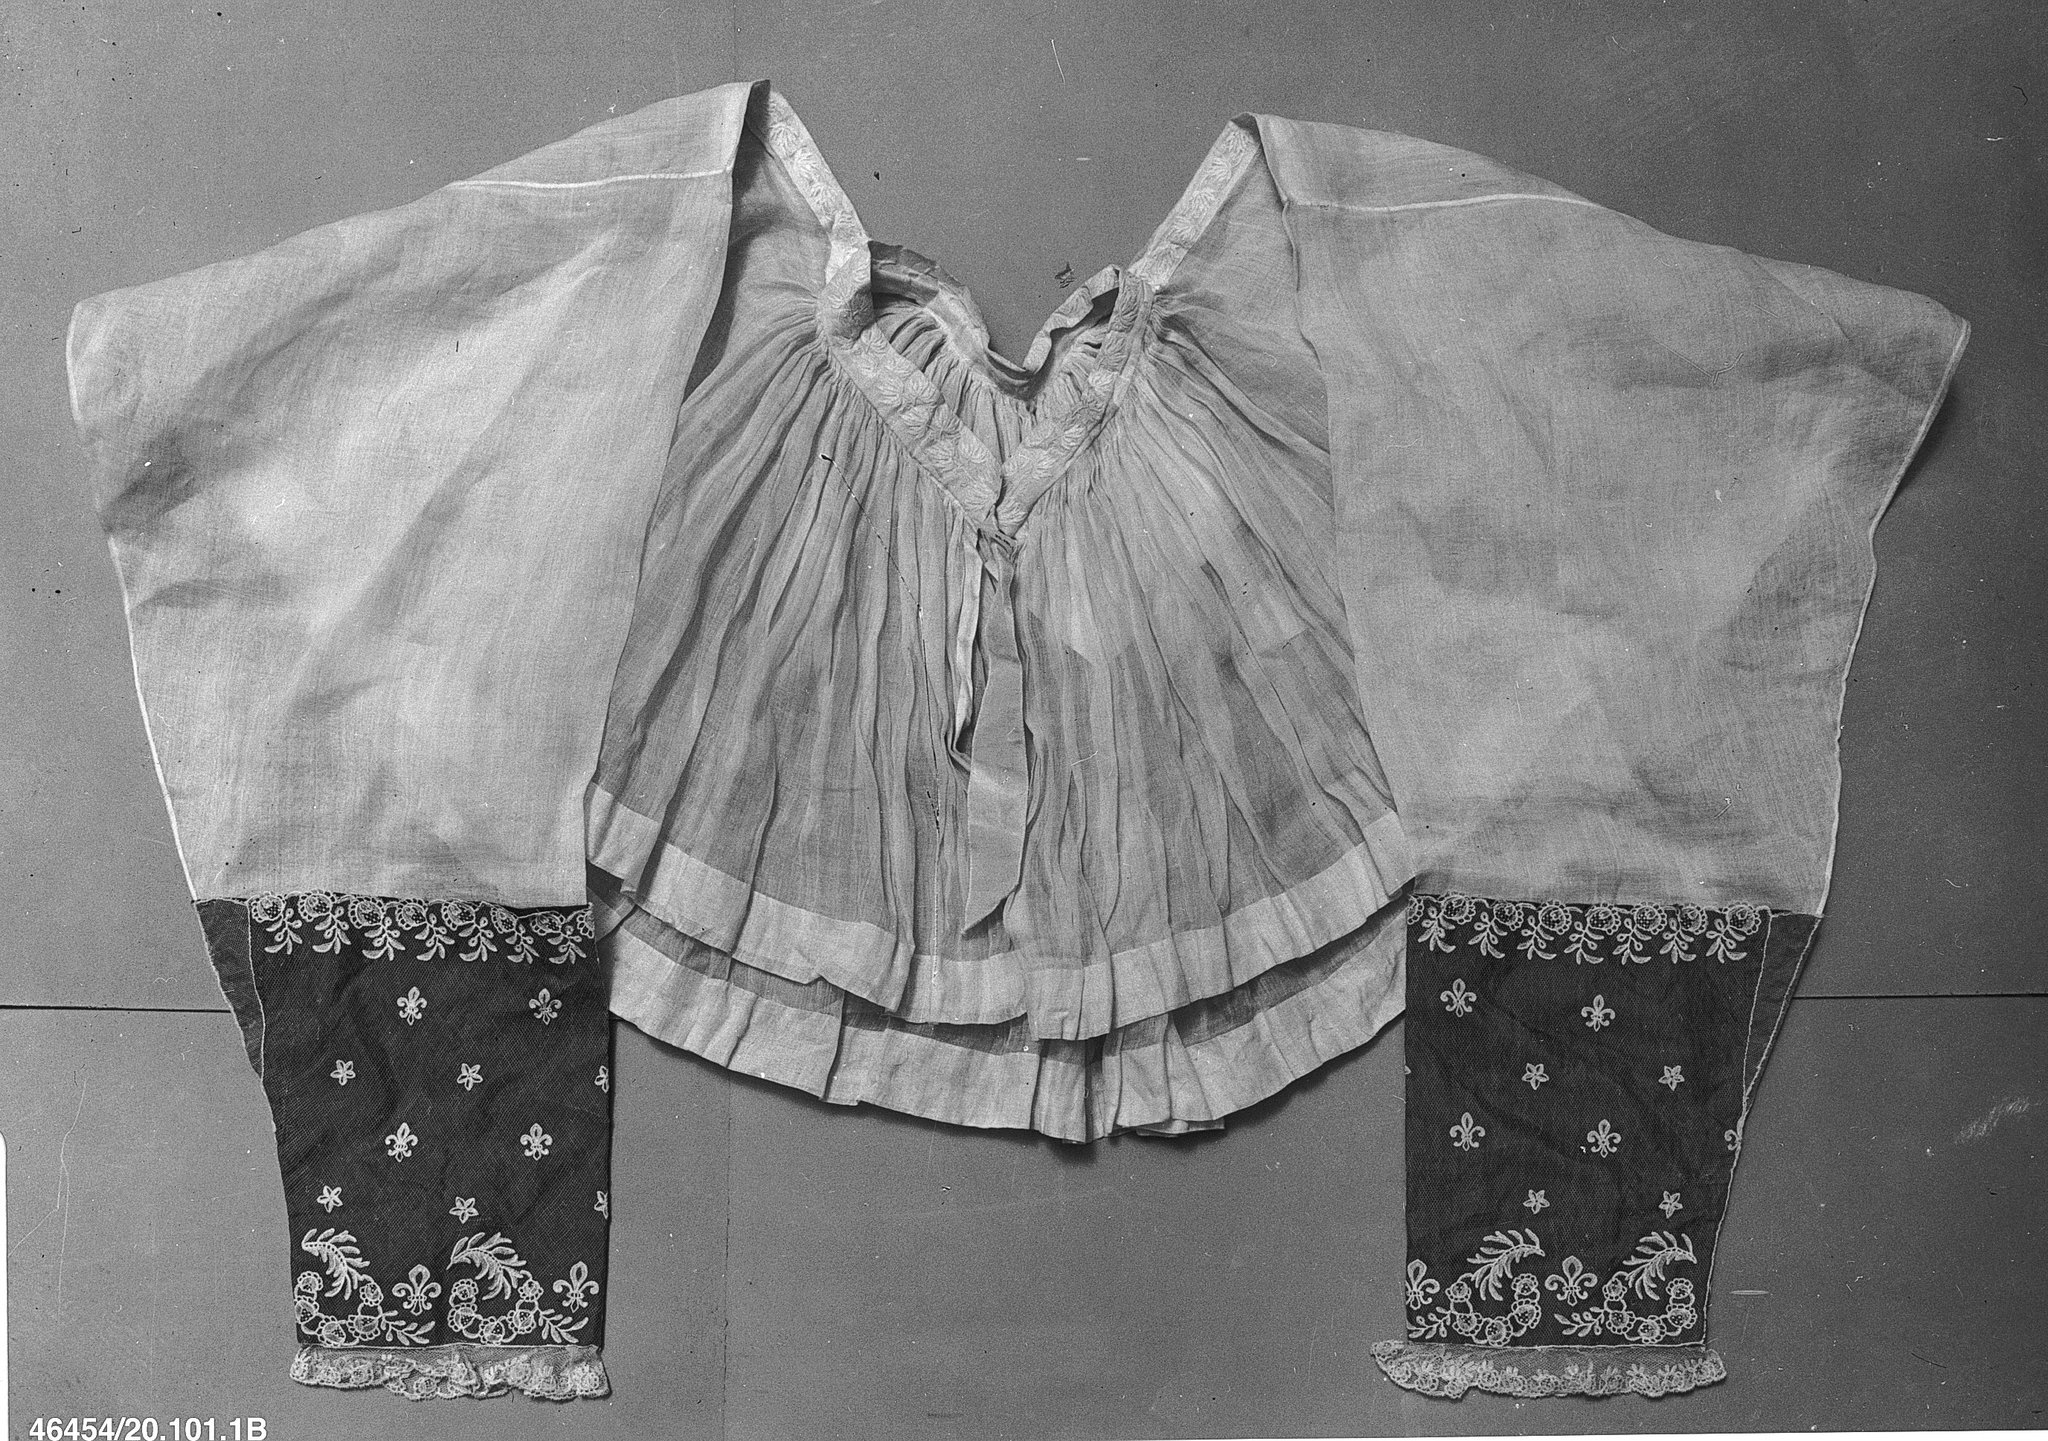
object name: rochet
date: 1824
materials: linen, silk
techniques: lace, embroidery